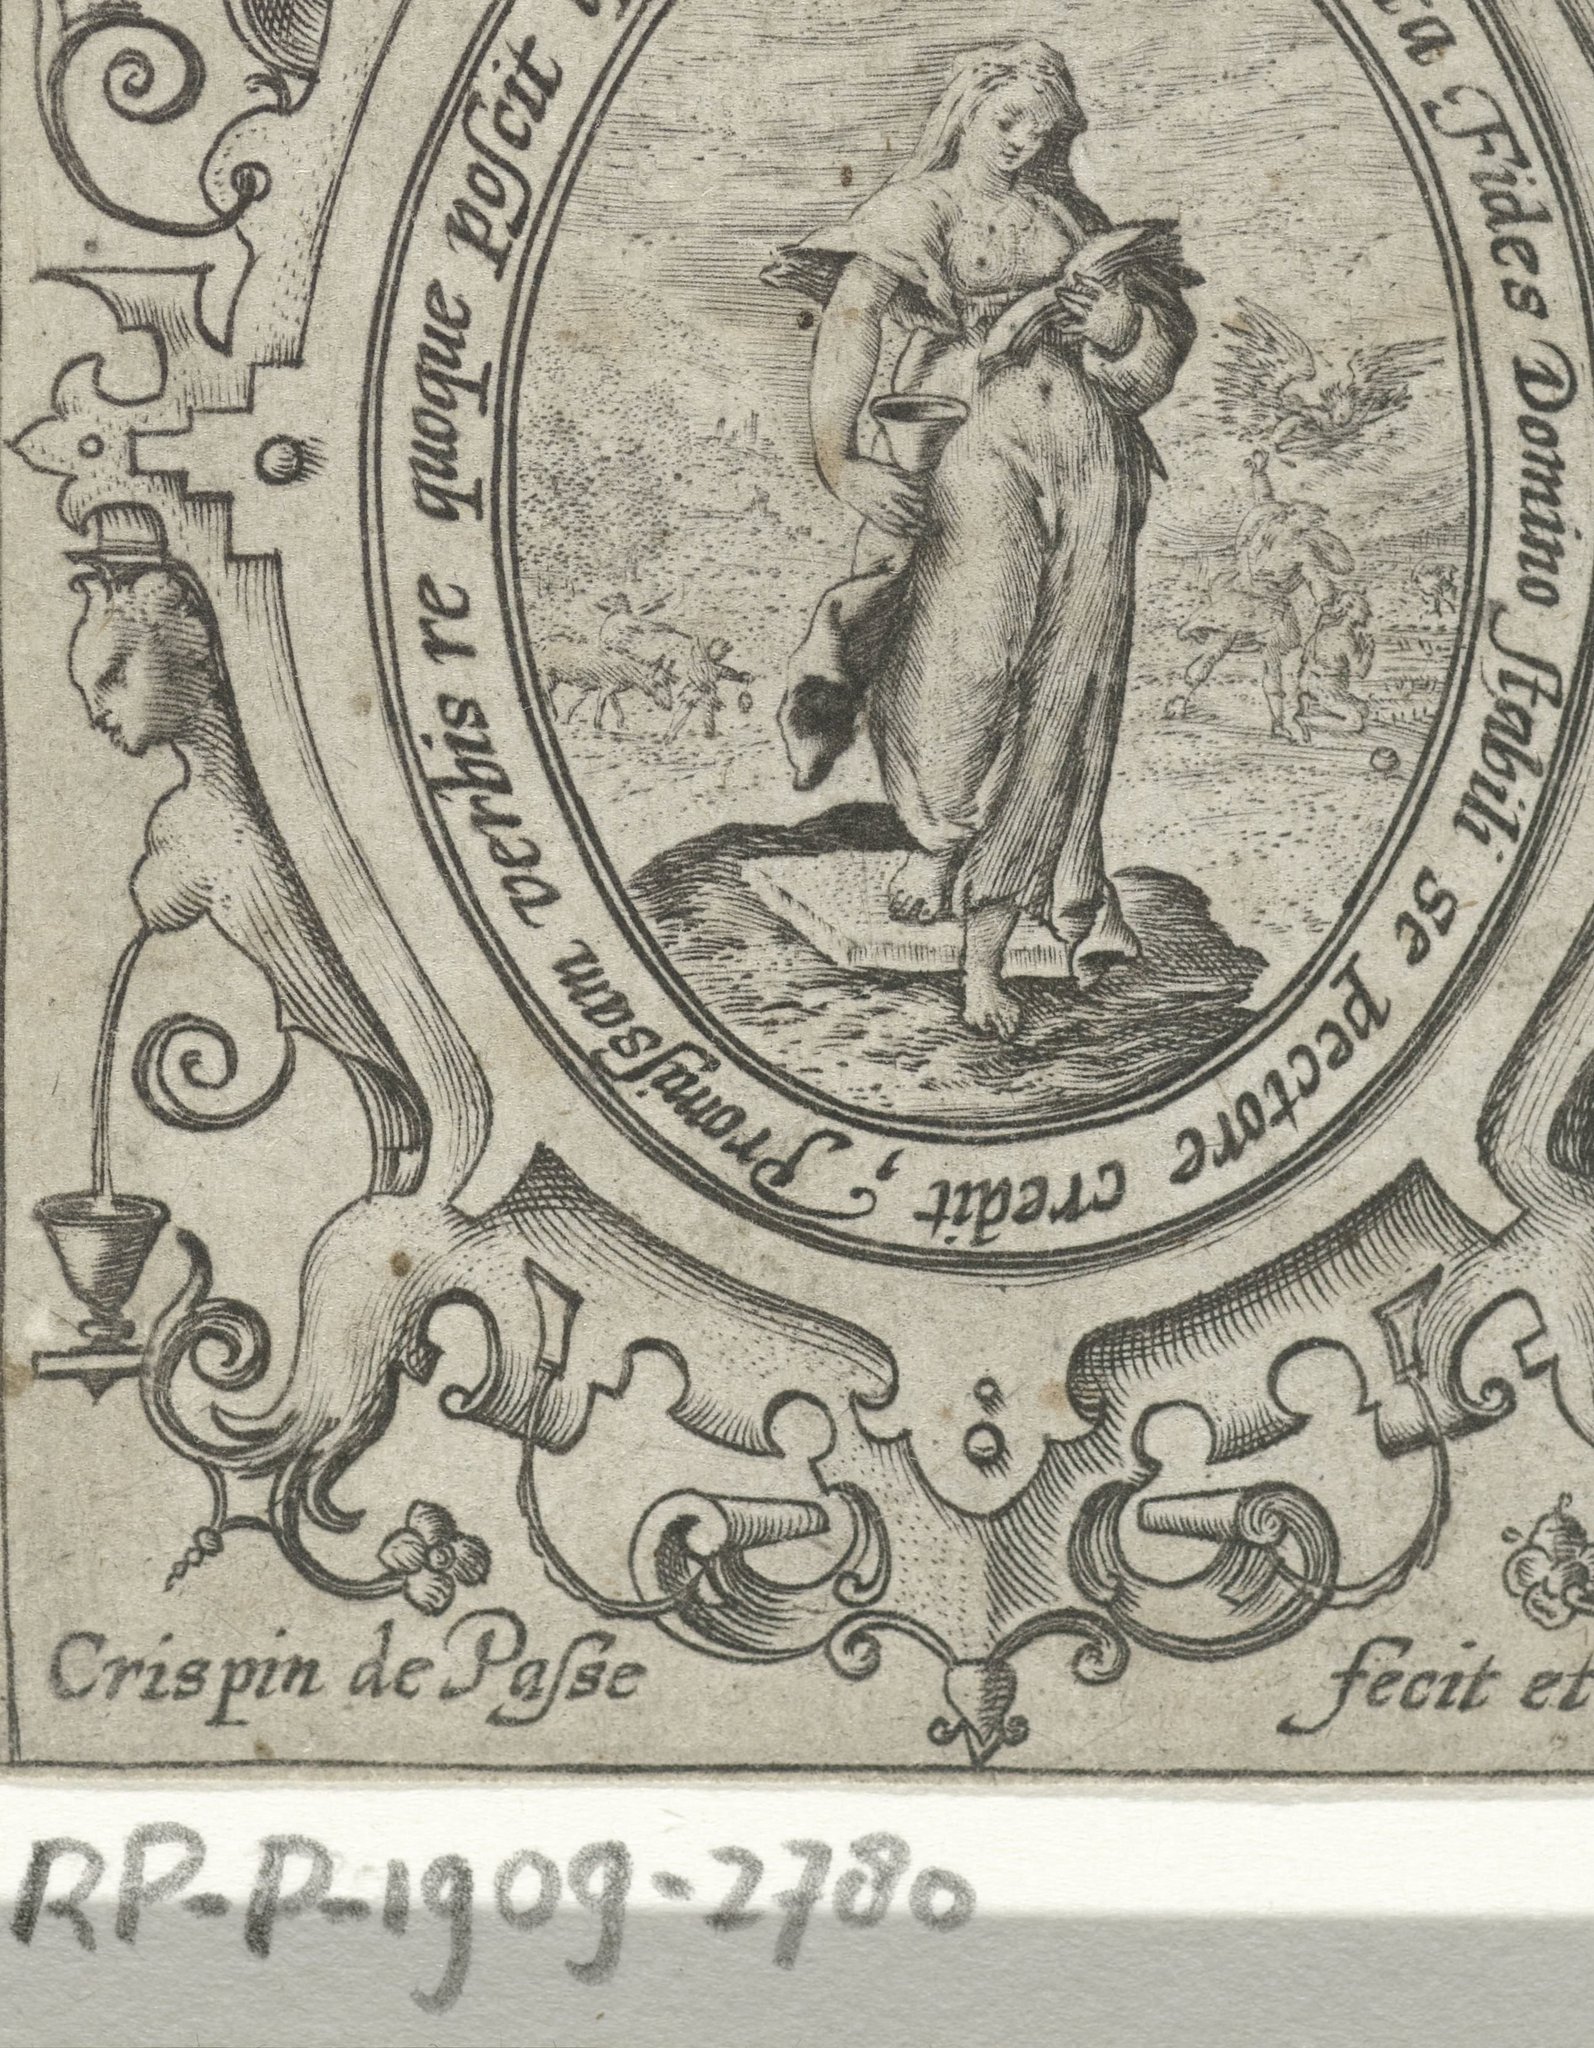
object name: print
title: De zeven deugden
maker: crispijn van de passe (i)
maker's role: draughtsman, print maker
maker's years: 1564-1637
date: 1574-1637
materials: paper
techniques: engraving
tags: faith, 'fides'; 'fede', 'fede catholica', 'fede christiana', 'fede christiana catholica' (ripa) ~ one of the three theological virtues, when abraham has his hand raised to kill isaac, an angel restrains abraham's hand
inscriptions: collector's mark: Lugt 2773, collector's mark: Lugt 2228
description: Landschap met de vrouwelijke personificatie van Geloof (Fides), een van de drie theologische deugden, met een miskelk en een opengeslagen boek in haar handen. Op de achtergrond het offer van Abraham. De voorstelling is gevat in een ornamentele omlijsting. Prent uit een serie met de zeven deugden.